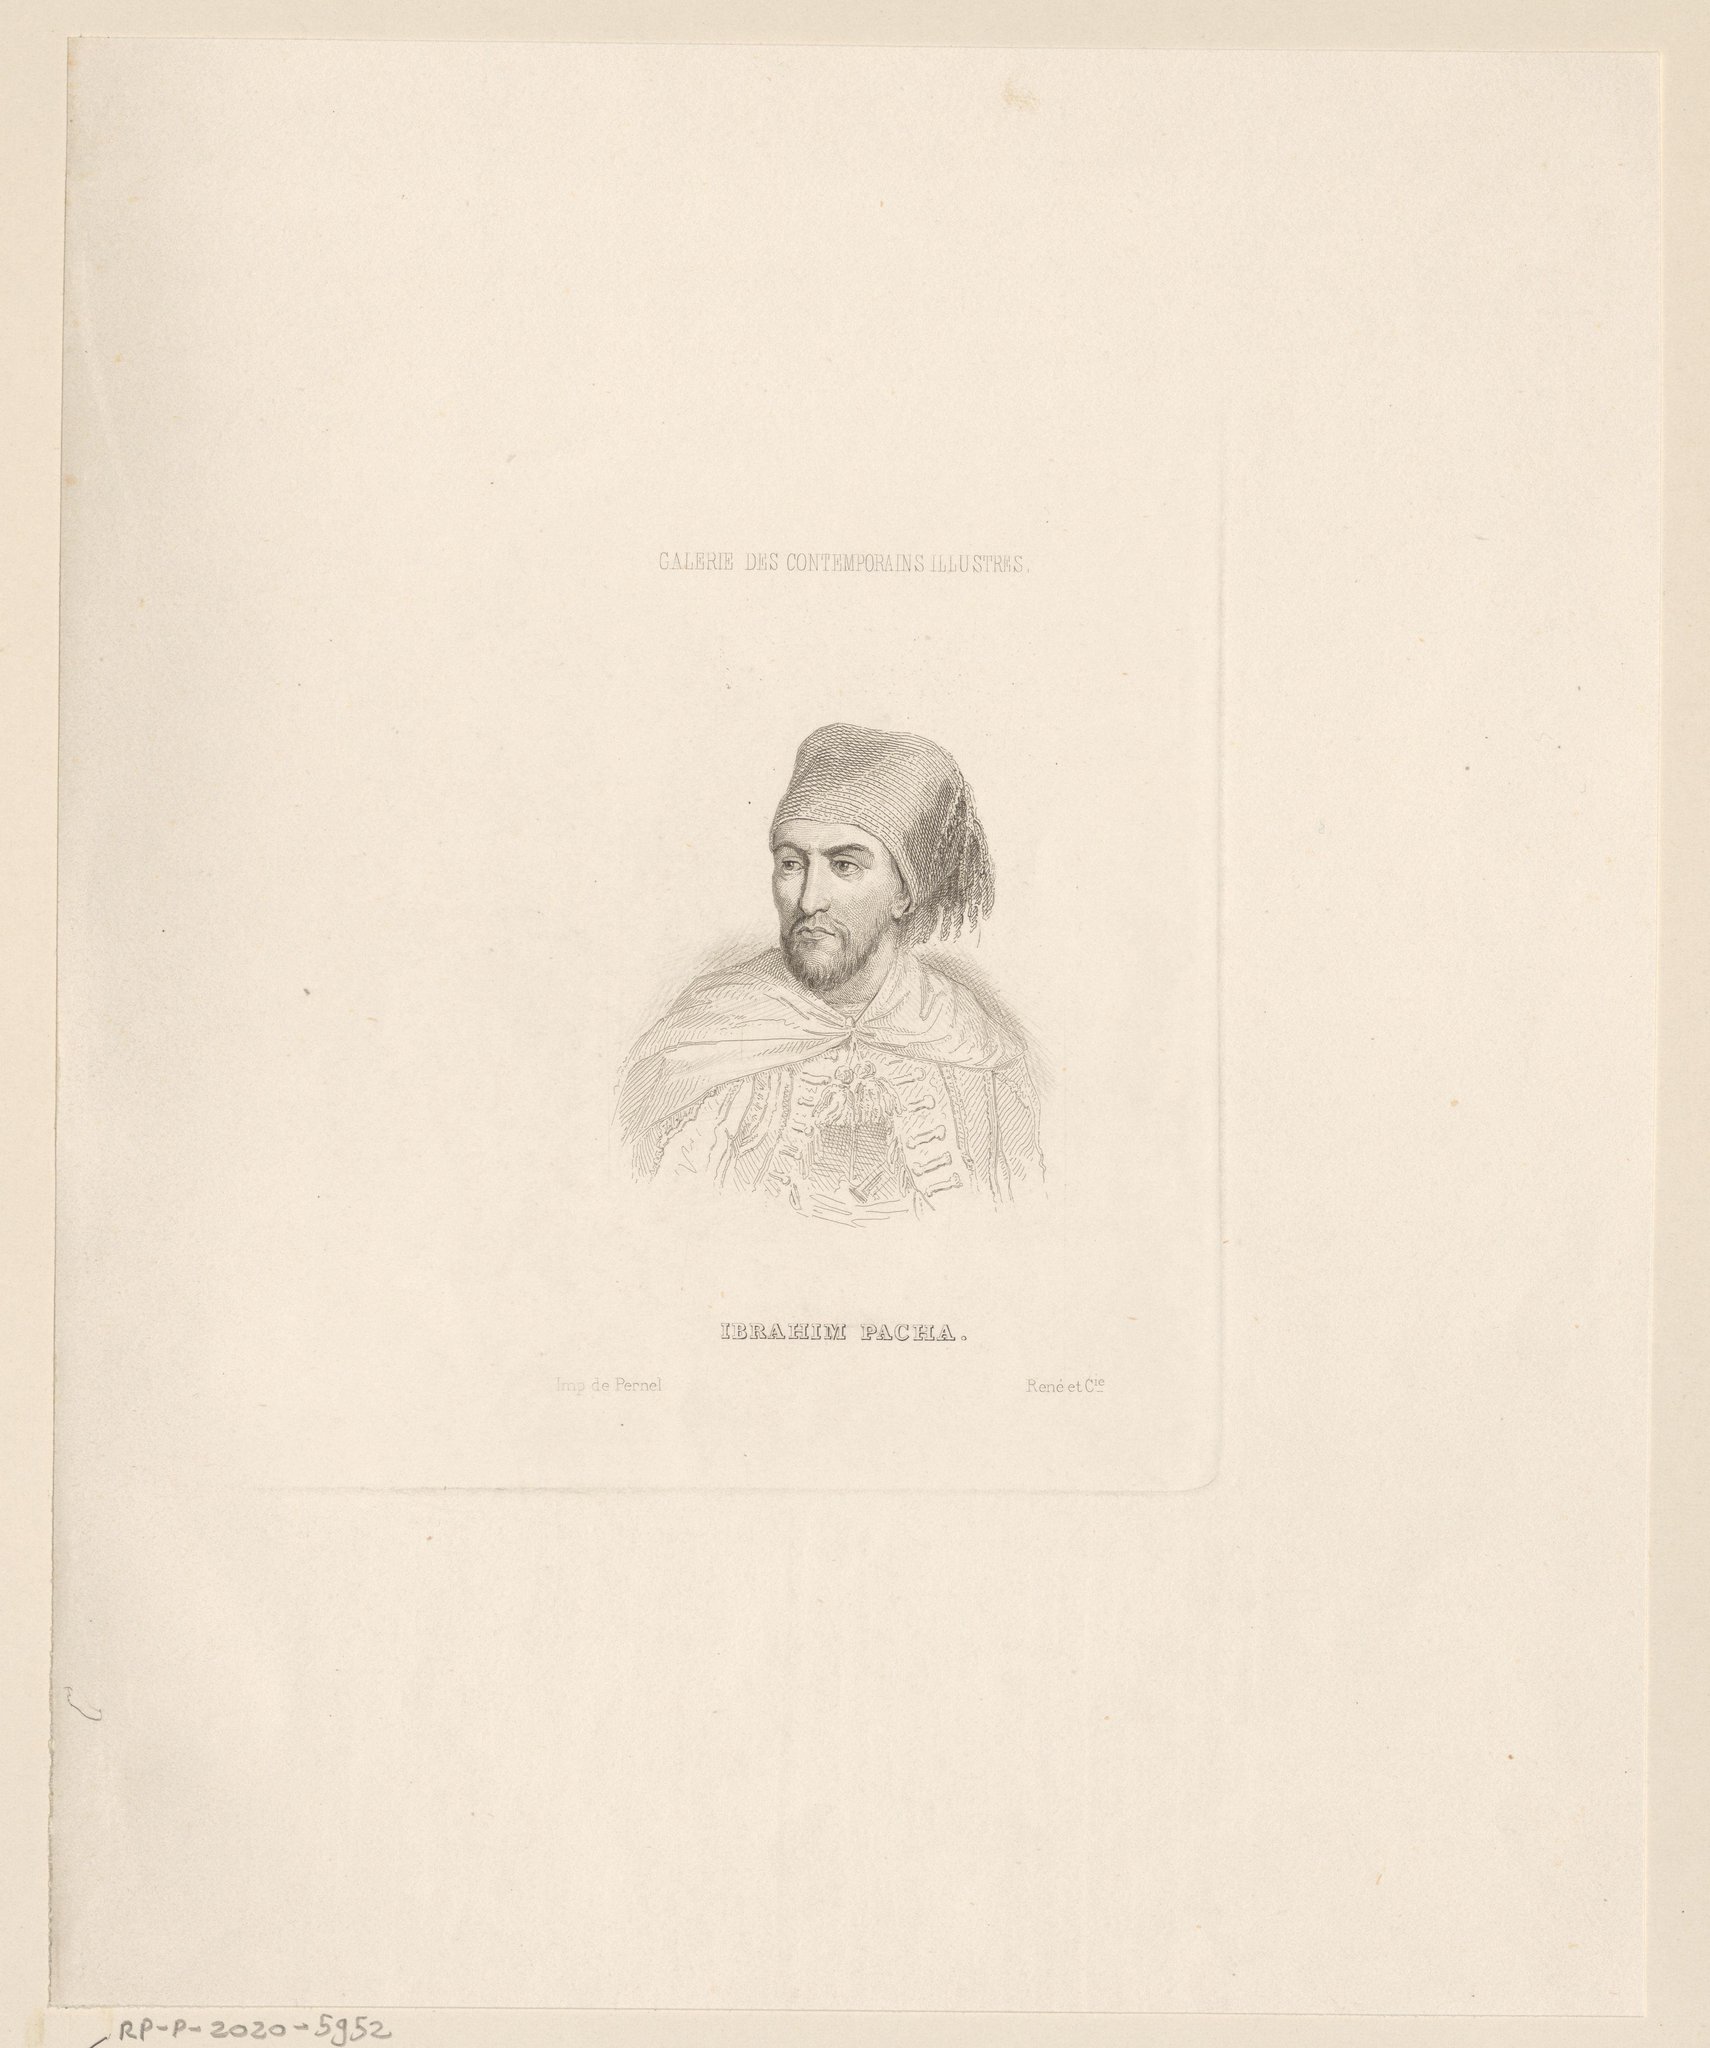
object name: print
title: Portret van Ibrahim, pasja van Egypte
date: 1842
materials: paper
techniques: etching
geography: paris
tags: head-gear, historical persons, ruler, sovereign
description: Prent waarschijnlijk uit: Galerie des contemporains illustres, par un homme de rien. Parijs: A. René & Cie, 1842, dl. 2.